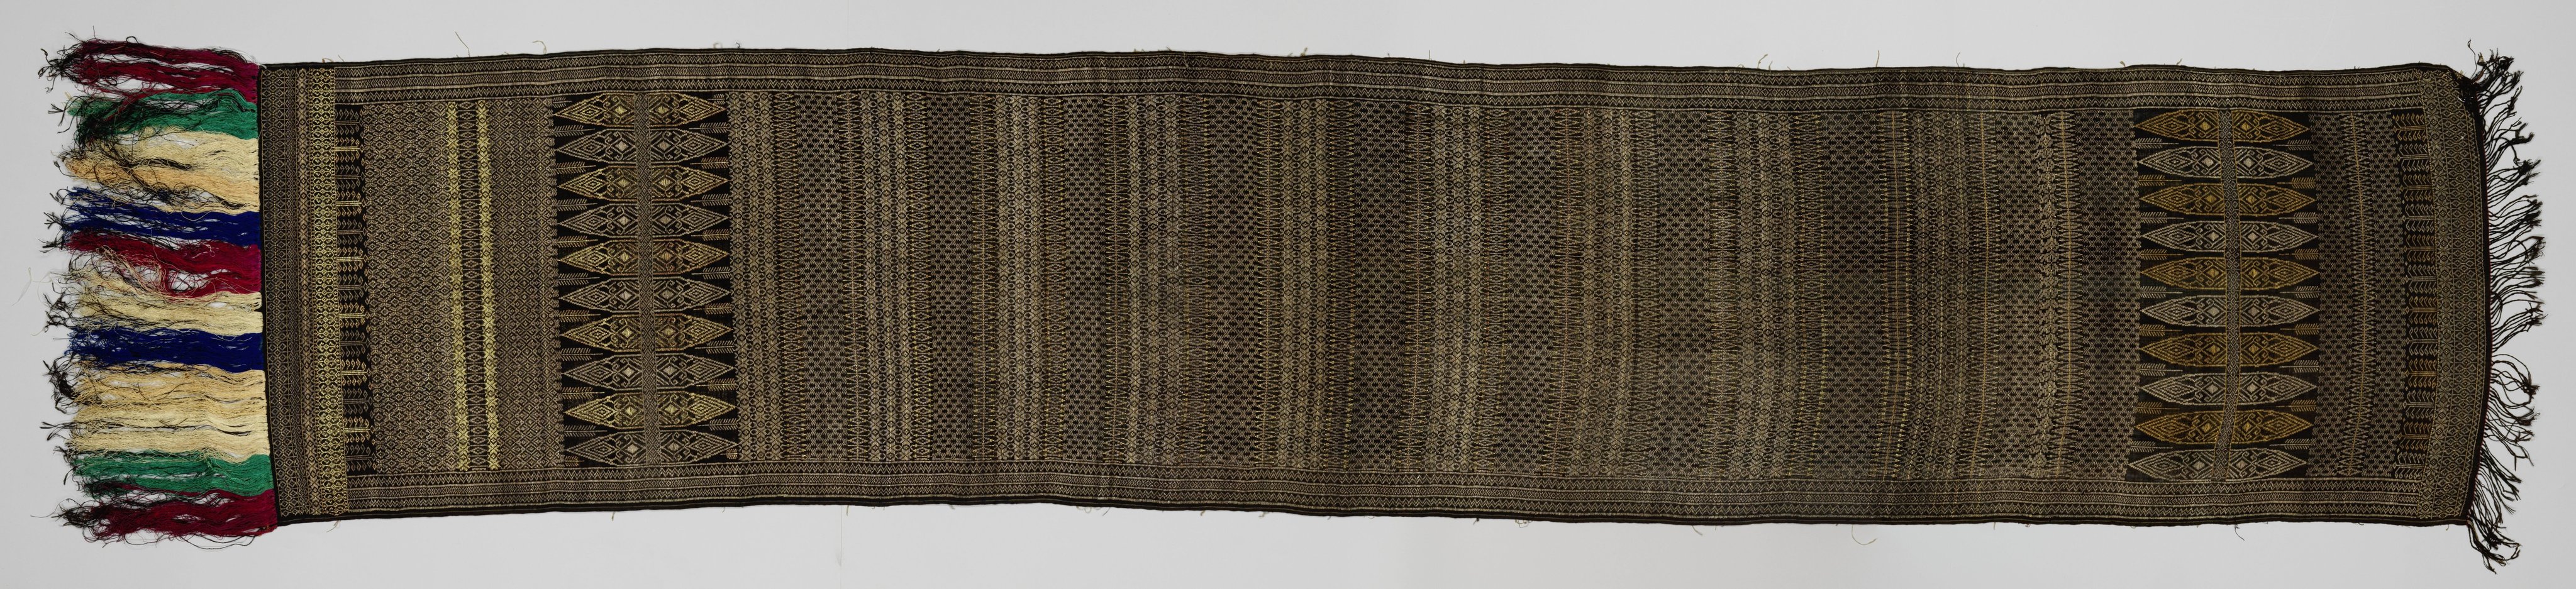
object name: schouderdoek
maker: Anonymous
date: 1900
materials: silk, thread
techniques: weave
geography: south sumatra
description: Doek met geometrische motieven en kleurige franje.